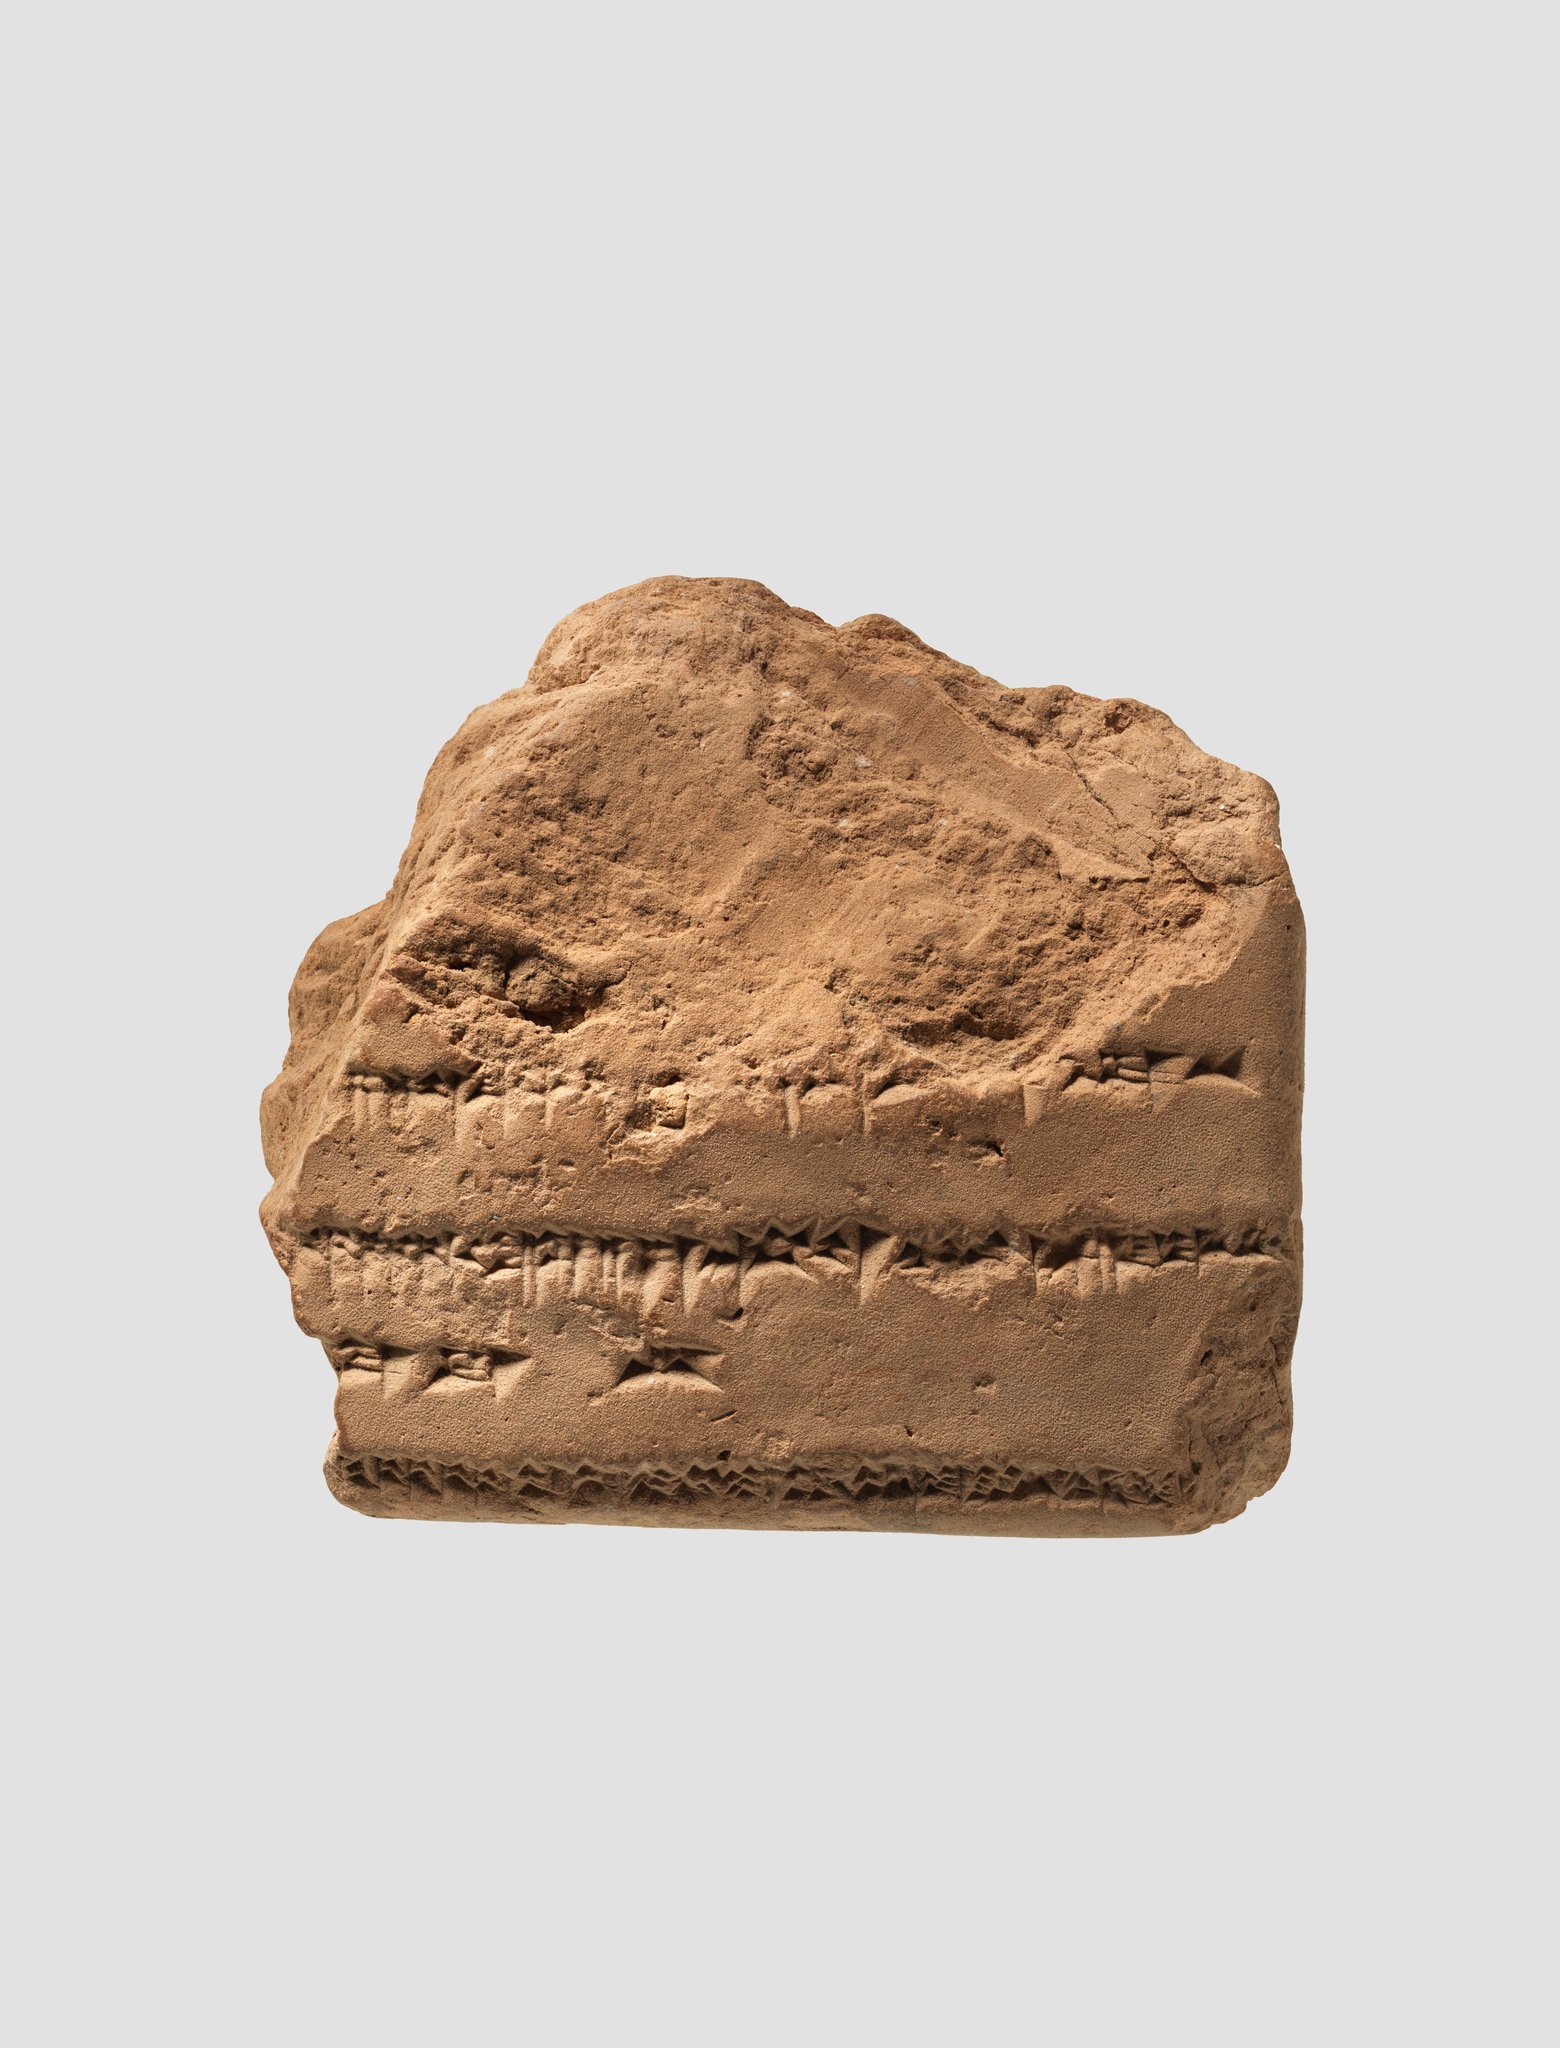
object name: cuneiform tablet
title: Cuneiform tablet: explanatory commentary on a list of materia medica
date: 333-1 BCE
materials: clay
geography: mesopotamia